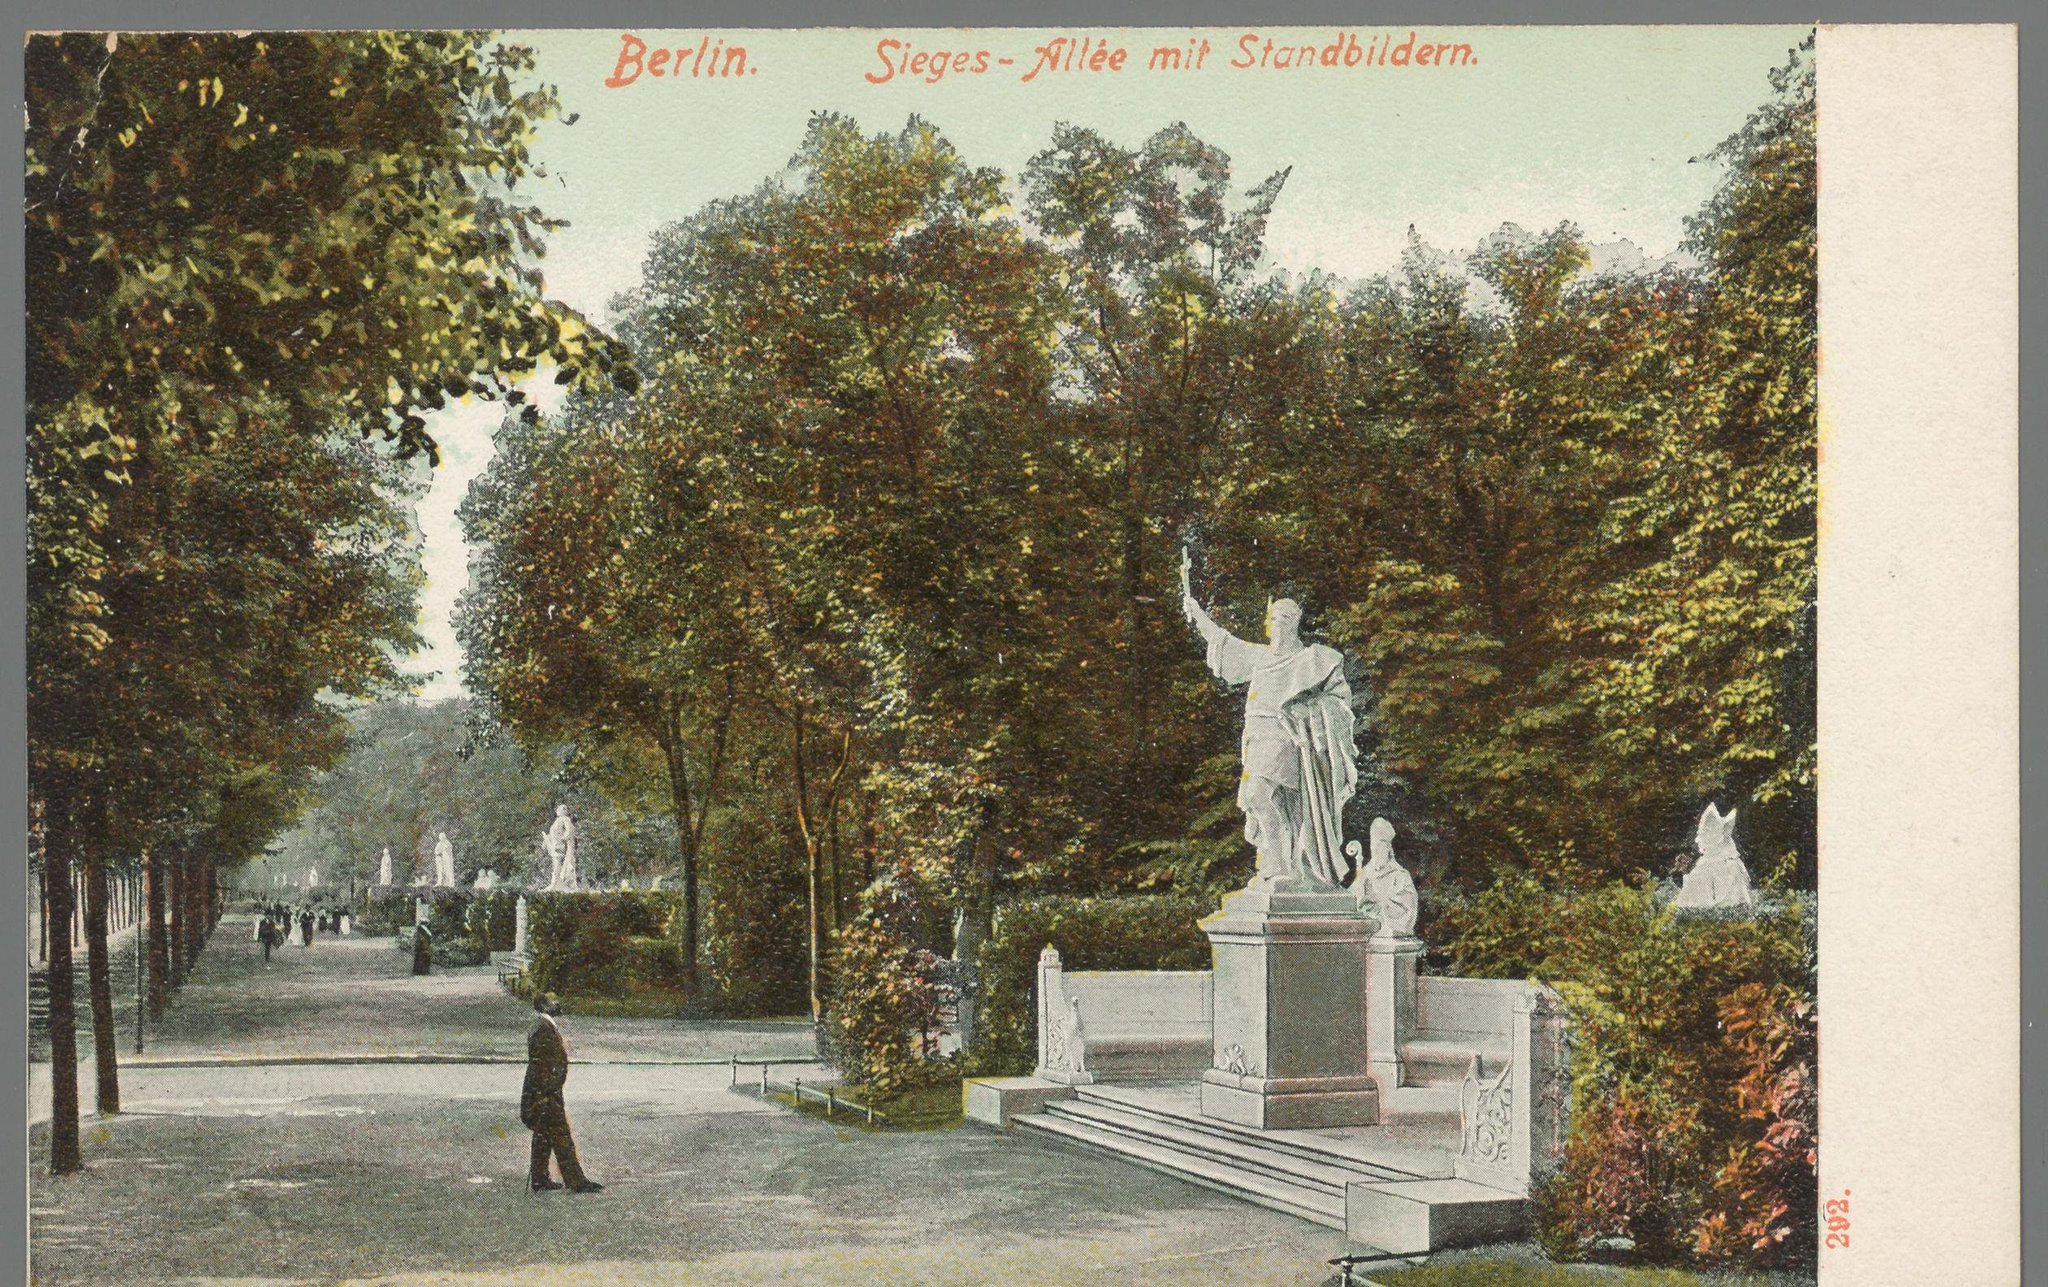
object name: ansichtkaart, prentbriefkaart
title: Berlin. Sieges-Allée mit Standbildern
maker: Anonymous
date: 1905-1930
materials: cardboard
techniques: lithograph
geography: berlin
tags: monument, statue, avenue, boulevard, promenade, esplanade